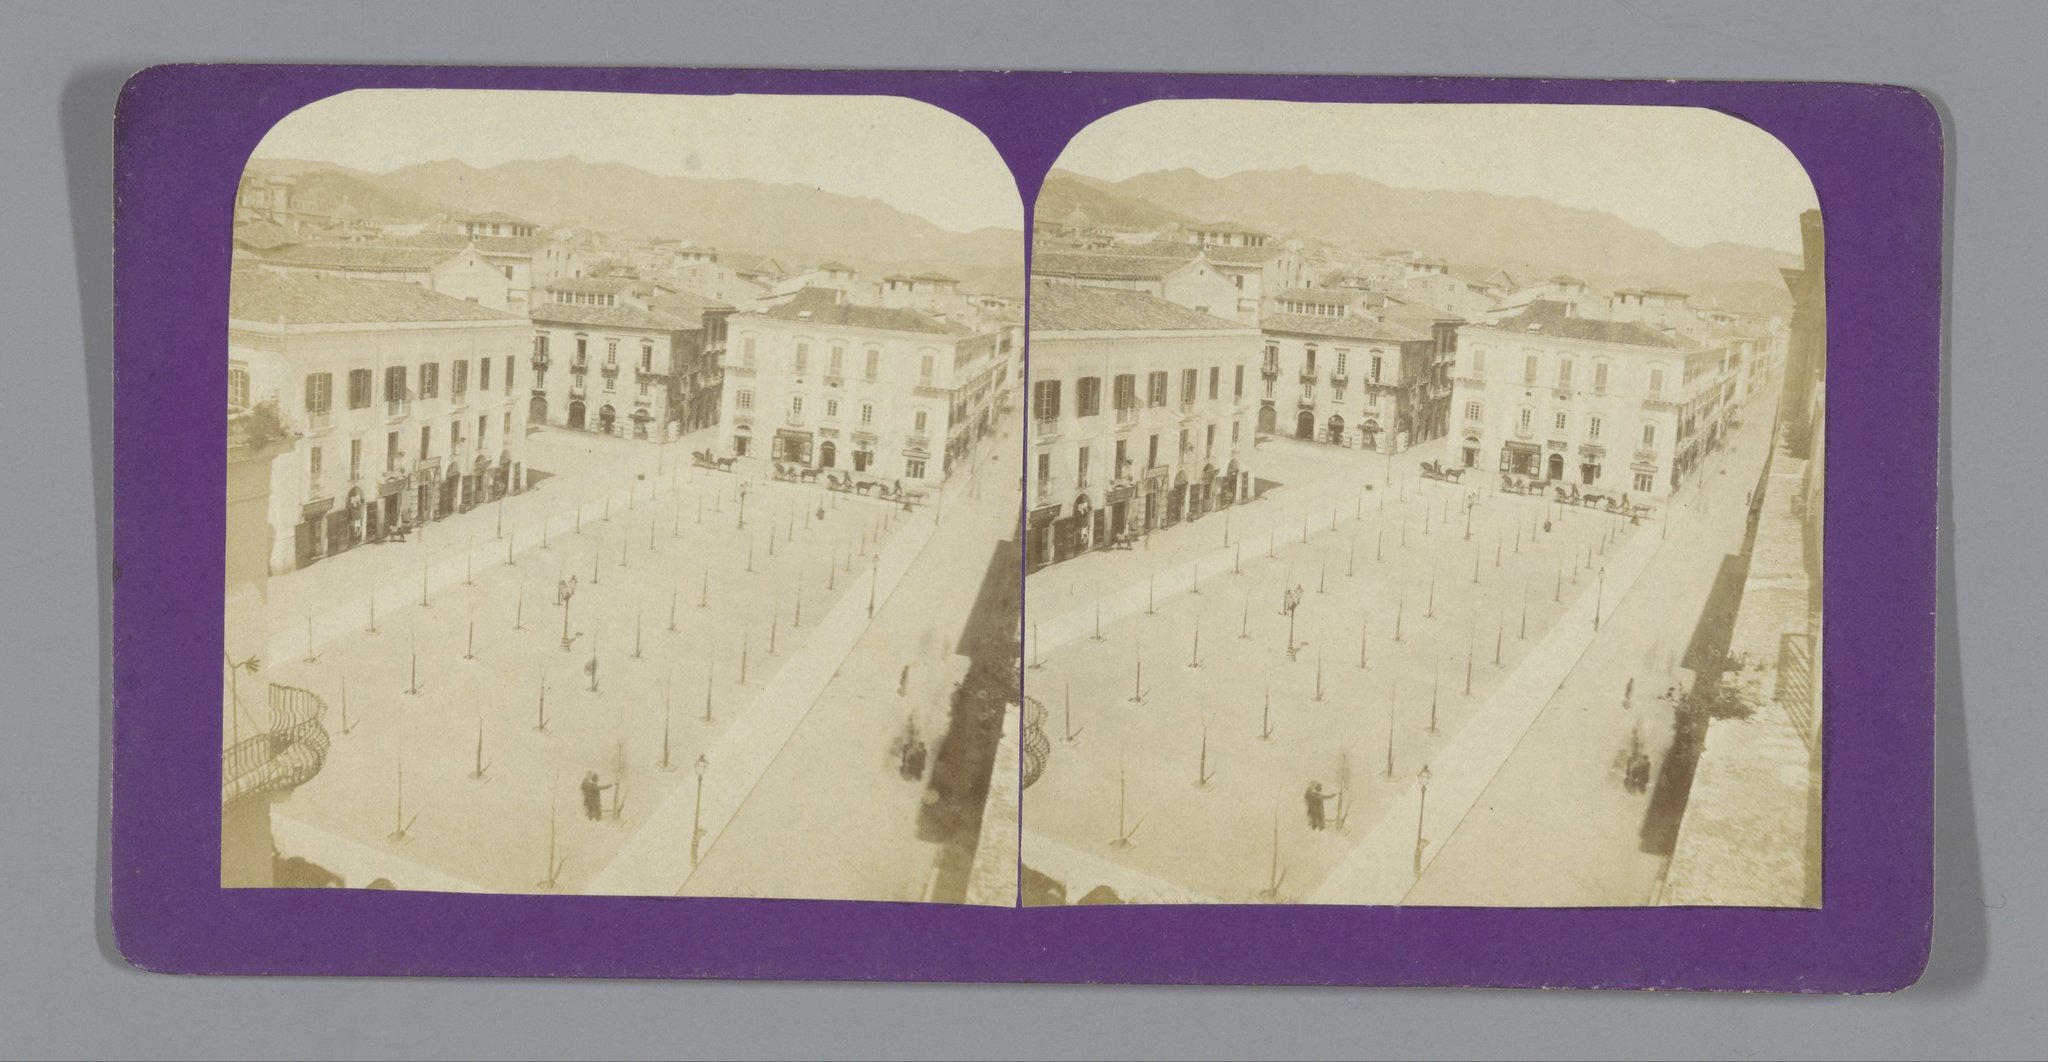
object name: stereograph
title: Vue prise de l'Hotel de Crinaeria (Messine)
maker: jean andrieu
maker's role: fotograaf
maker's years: 1816-1872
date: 1862-1876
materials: cardboard, paper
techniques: albumen print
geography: messina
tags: square, place, circus, etc.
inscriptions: title: ‘1440 Vue prise de l'hotel de Crinaeria (Messine)’